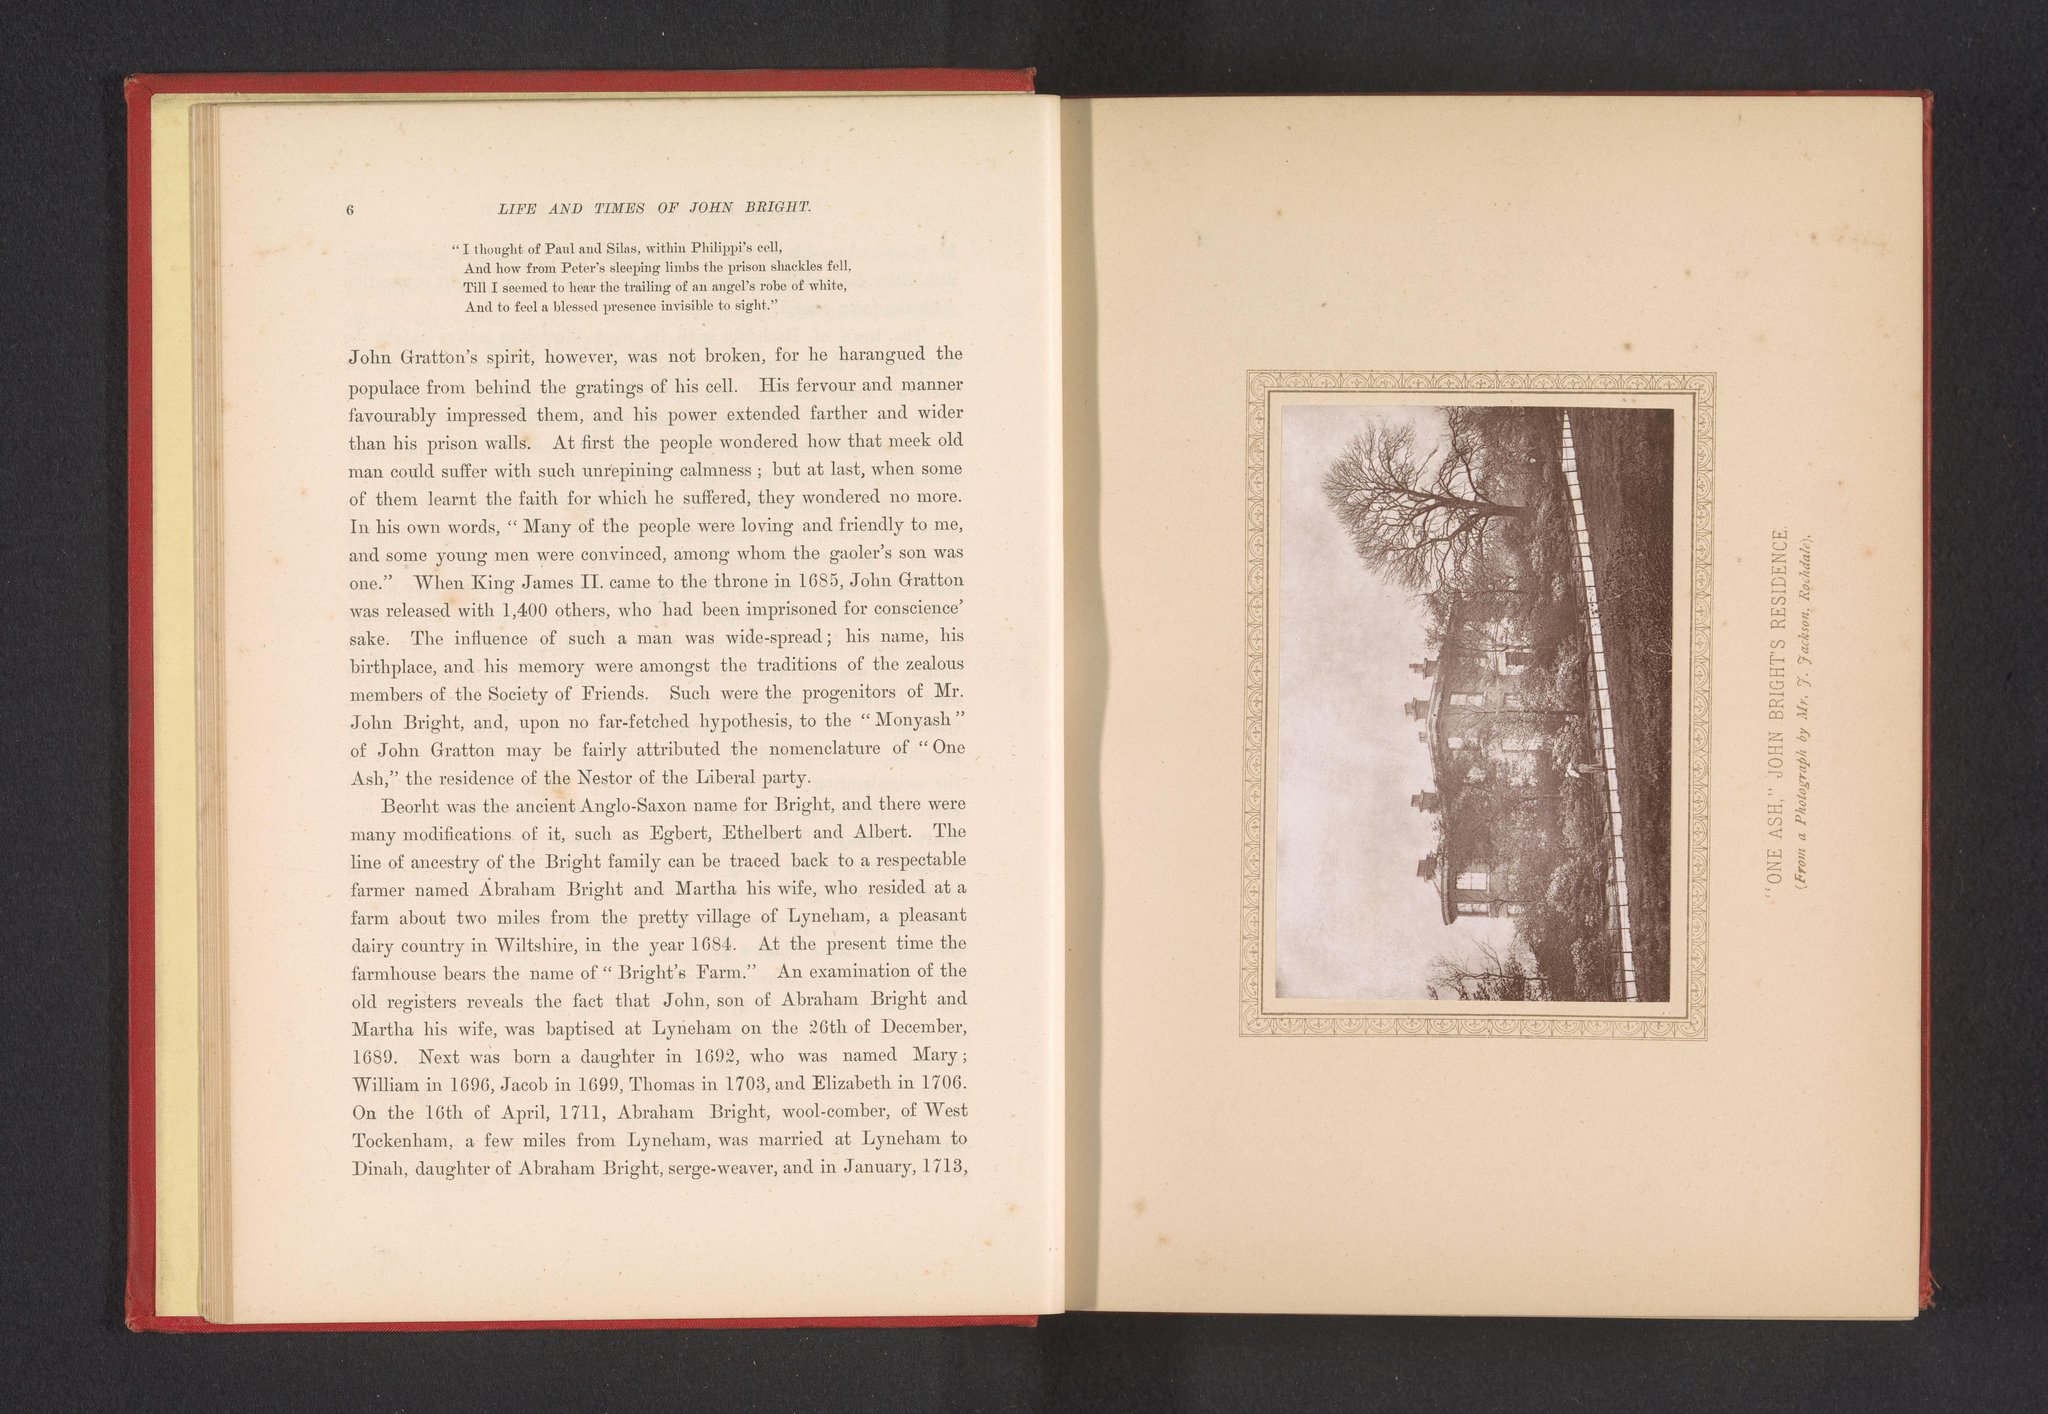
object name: page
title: “One Ash,” John Bright's residence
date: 1874-1884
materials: paper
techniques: woodburytype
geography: rochdale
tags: country-house